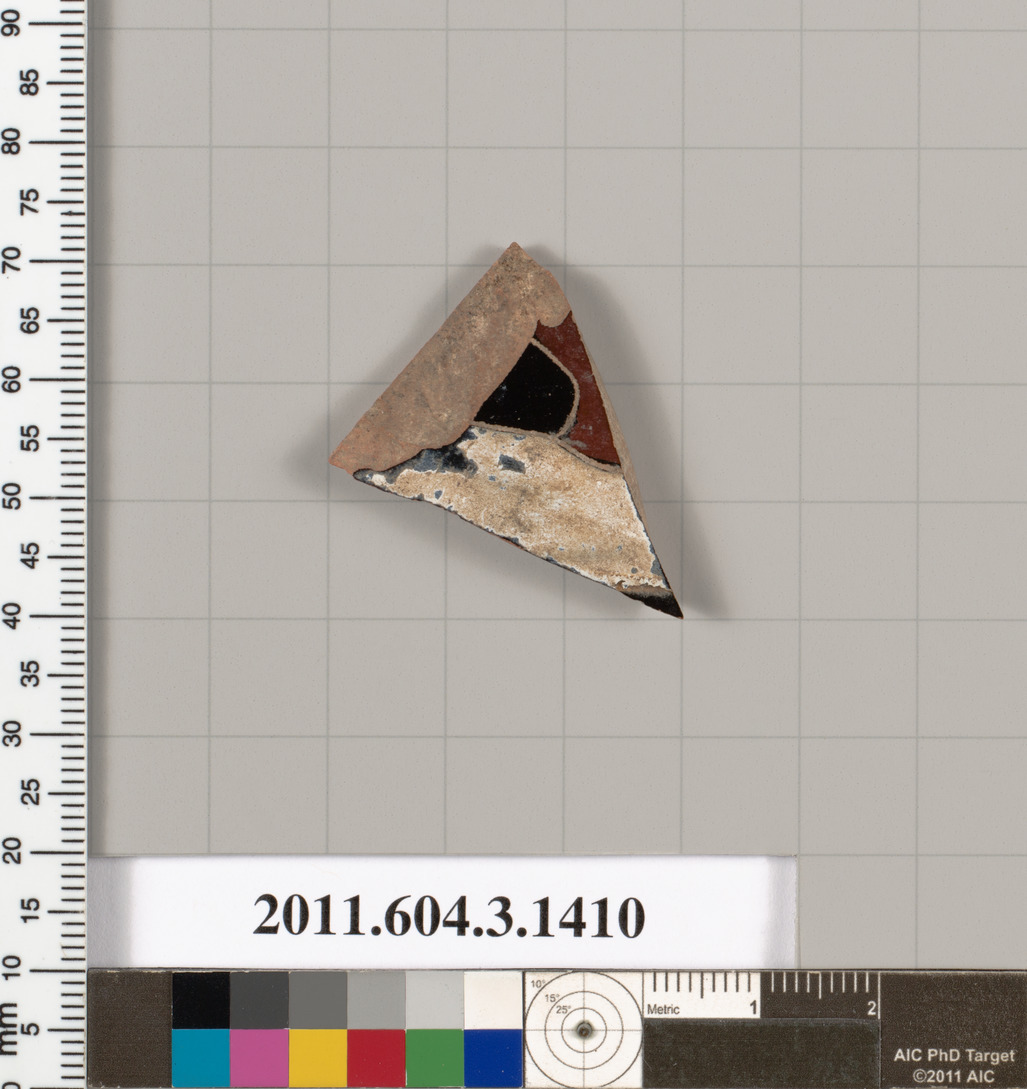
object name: skyphos fragment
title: Terracotta fragment of a skyphos (deep drinking cup)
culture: greek, attic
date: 534-468 BCE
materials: terracotta